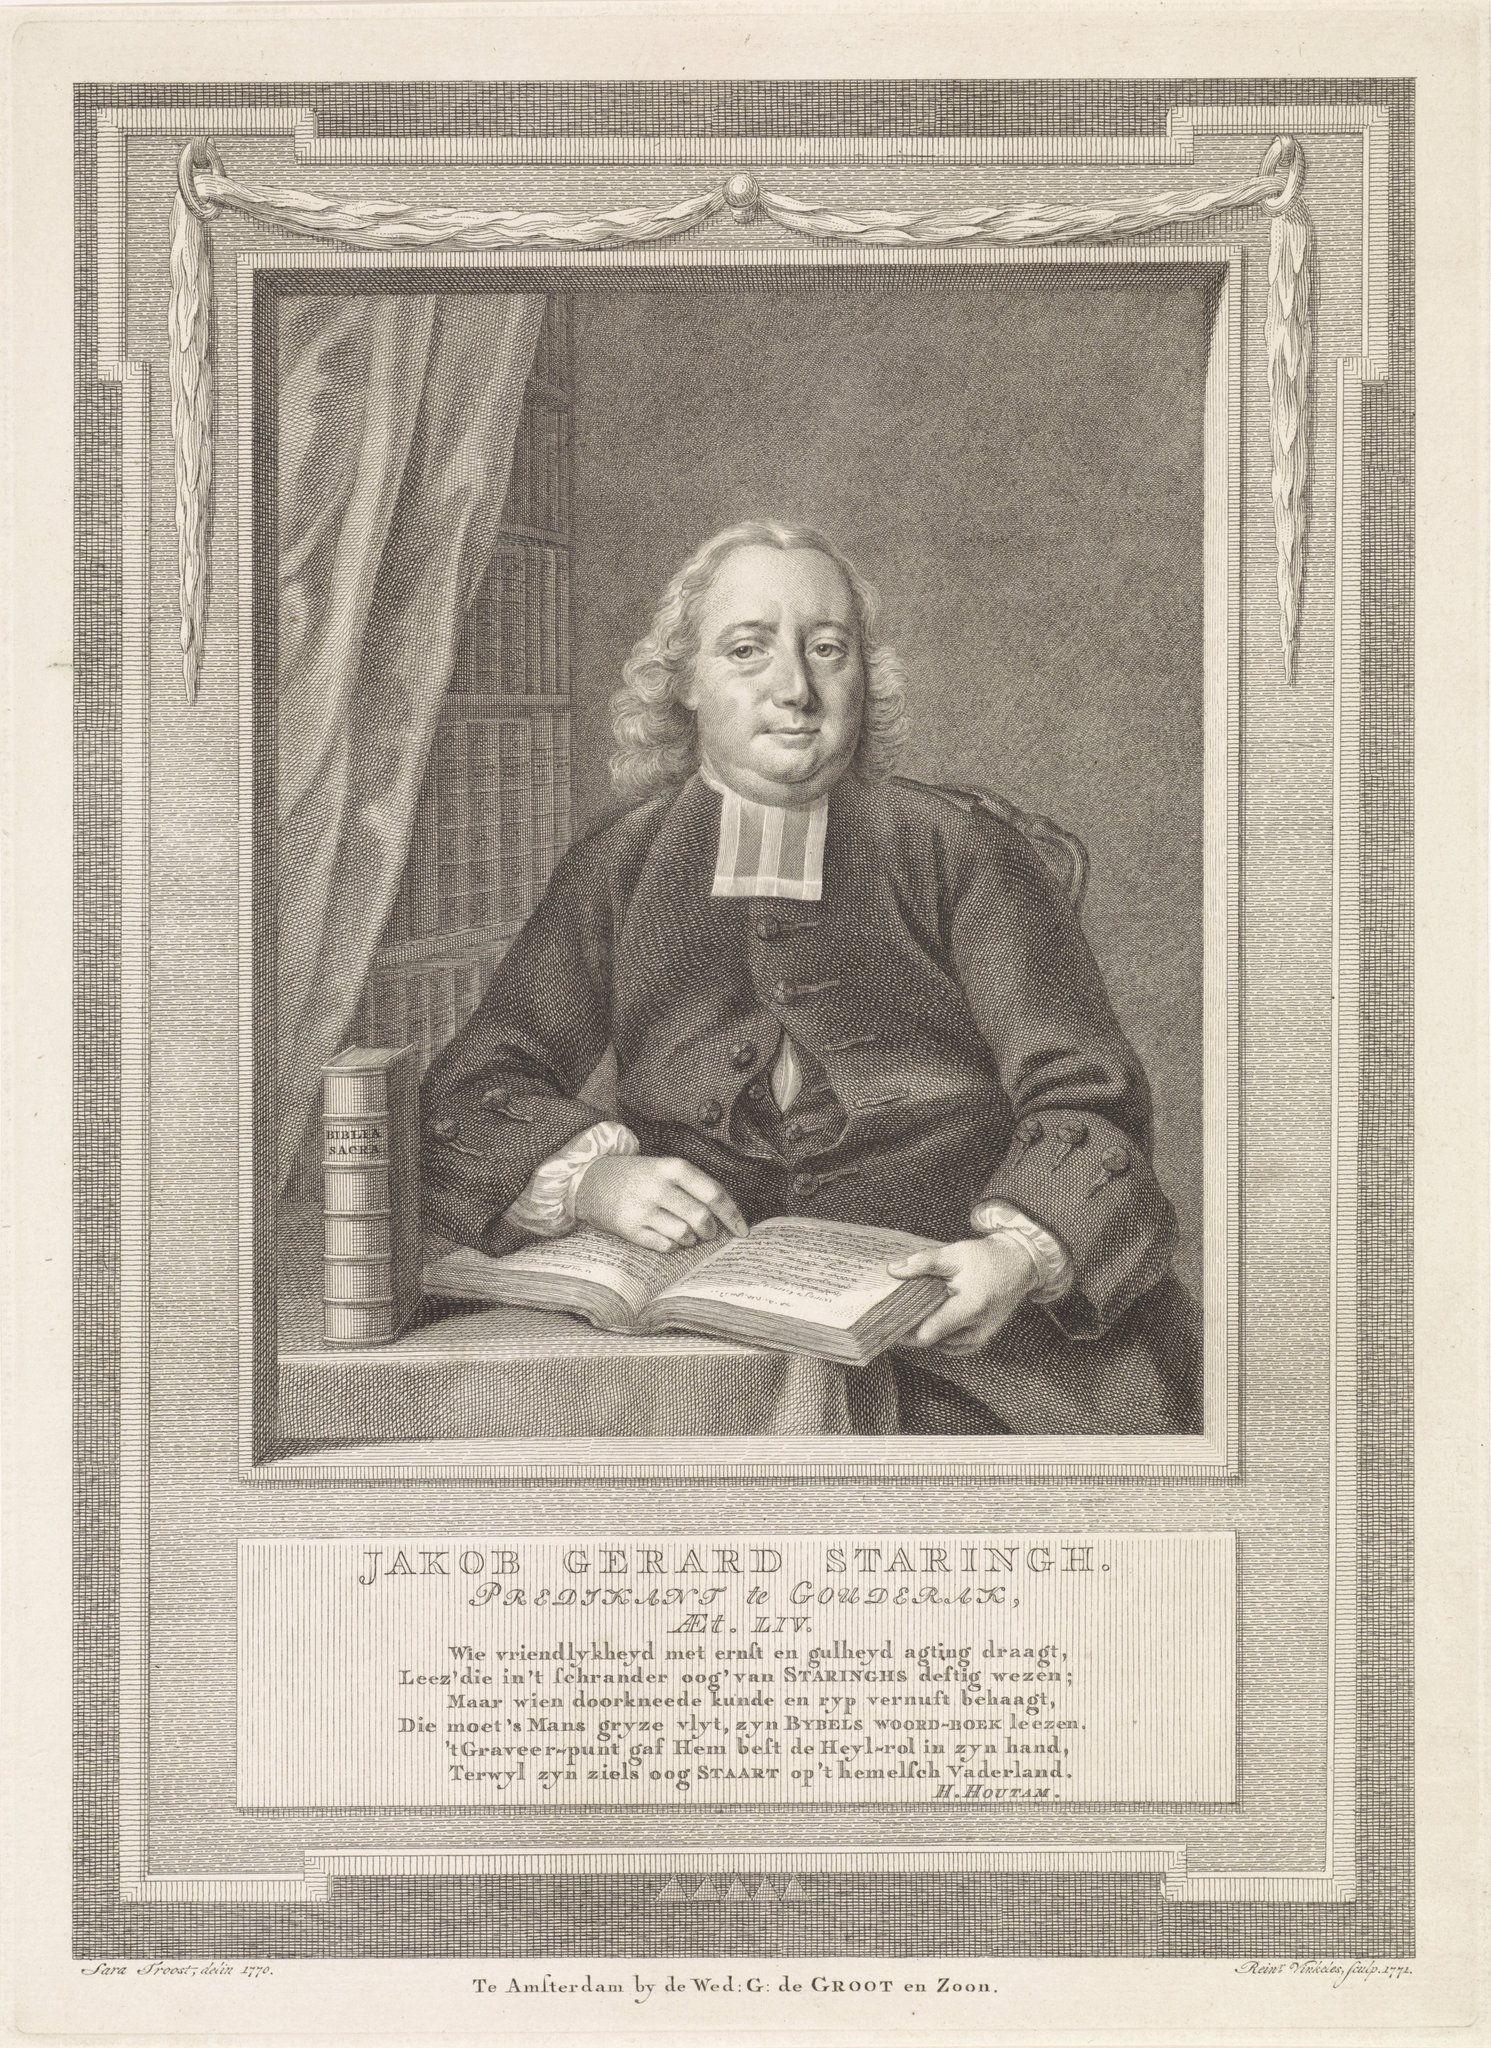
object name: print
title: Portret van Jacobus Gerardus Staring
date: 1771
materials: paper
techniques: engraving, etching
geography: amsterdam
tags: study; 'studiolo'; library, the bible as a book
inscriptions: collector's mark: Lugt 2228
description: Portret van Jacobus Gerardus Staring, predikant te Gouderak. Hij zit achter een tafel waarop een opengeslagen boek en een bijbel. Op de achtergrond een boekenkast.